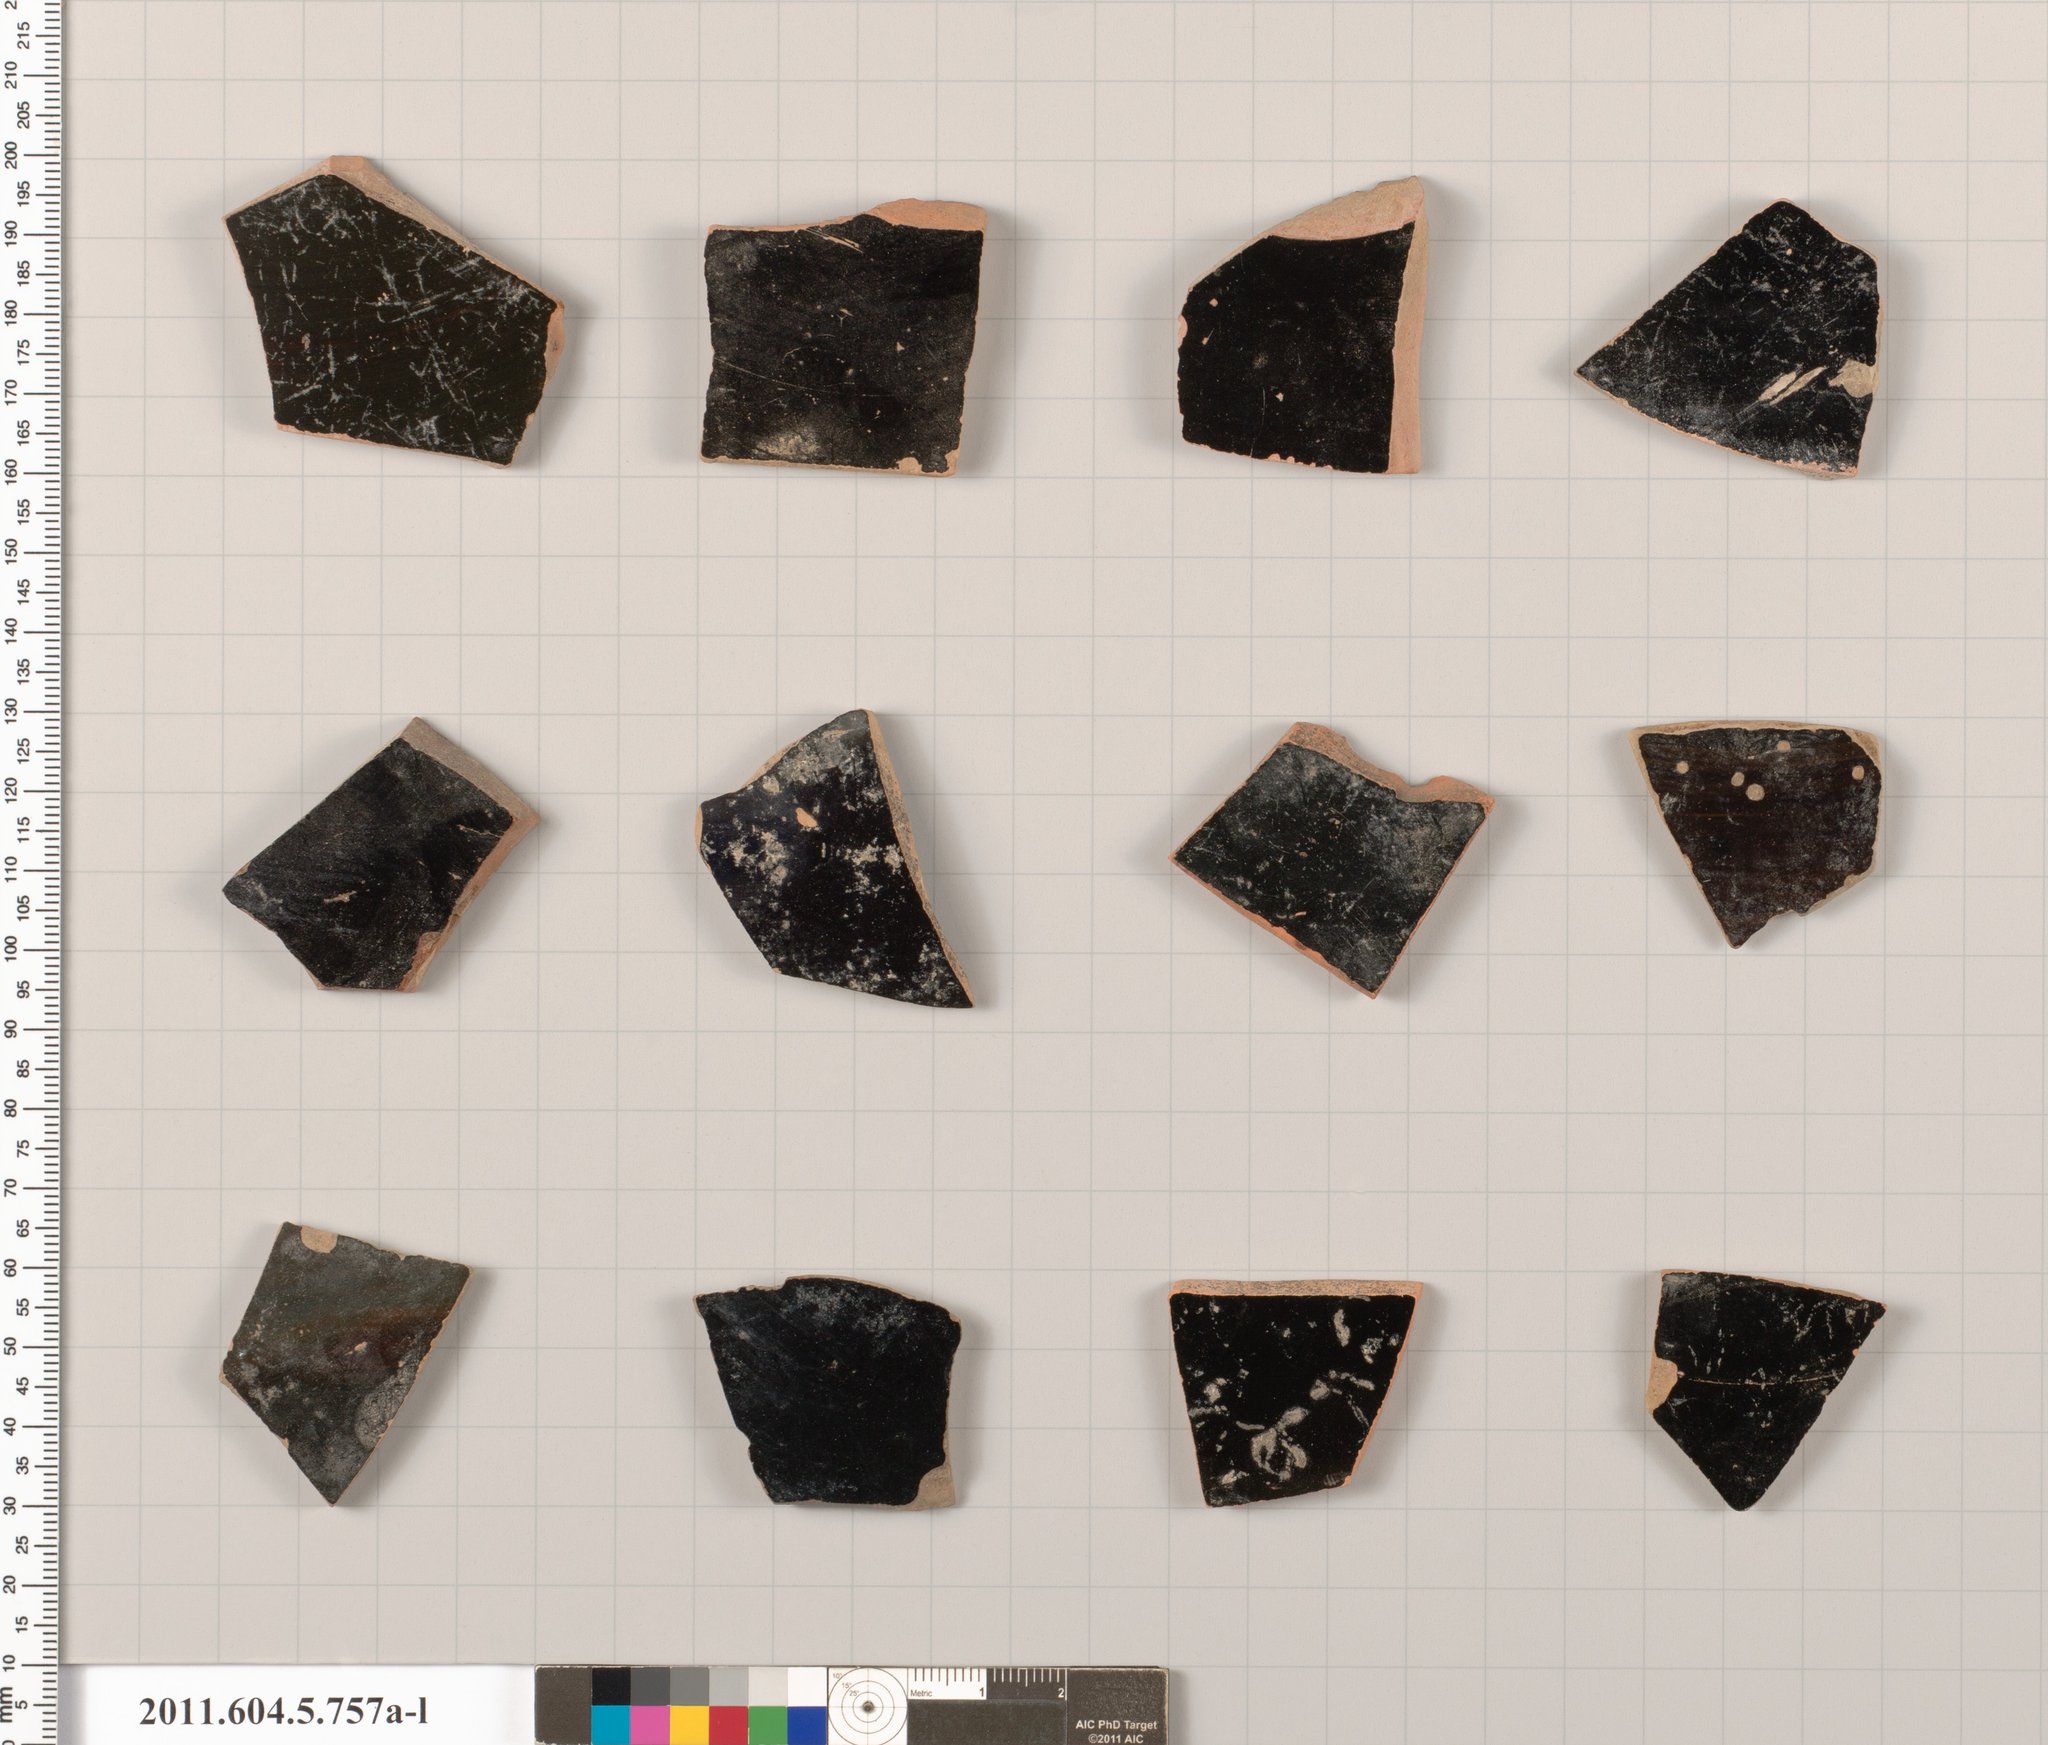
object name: kylix fragment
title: Terracotta fragments of kylikes (drinking cups)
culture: greek, attic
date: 600-401 BCE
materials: terracotta